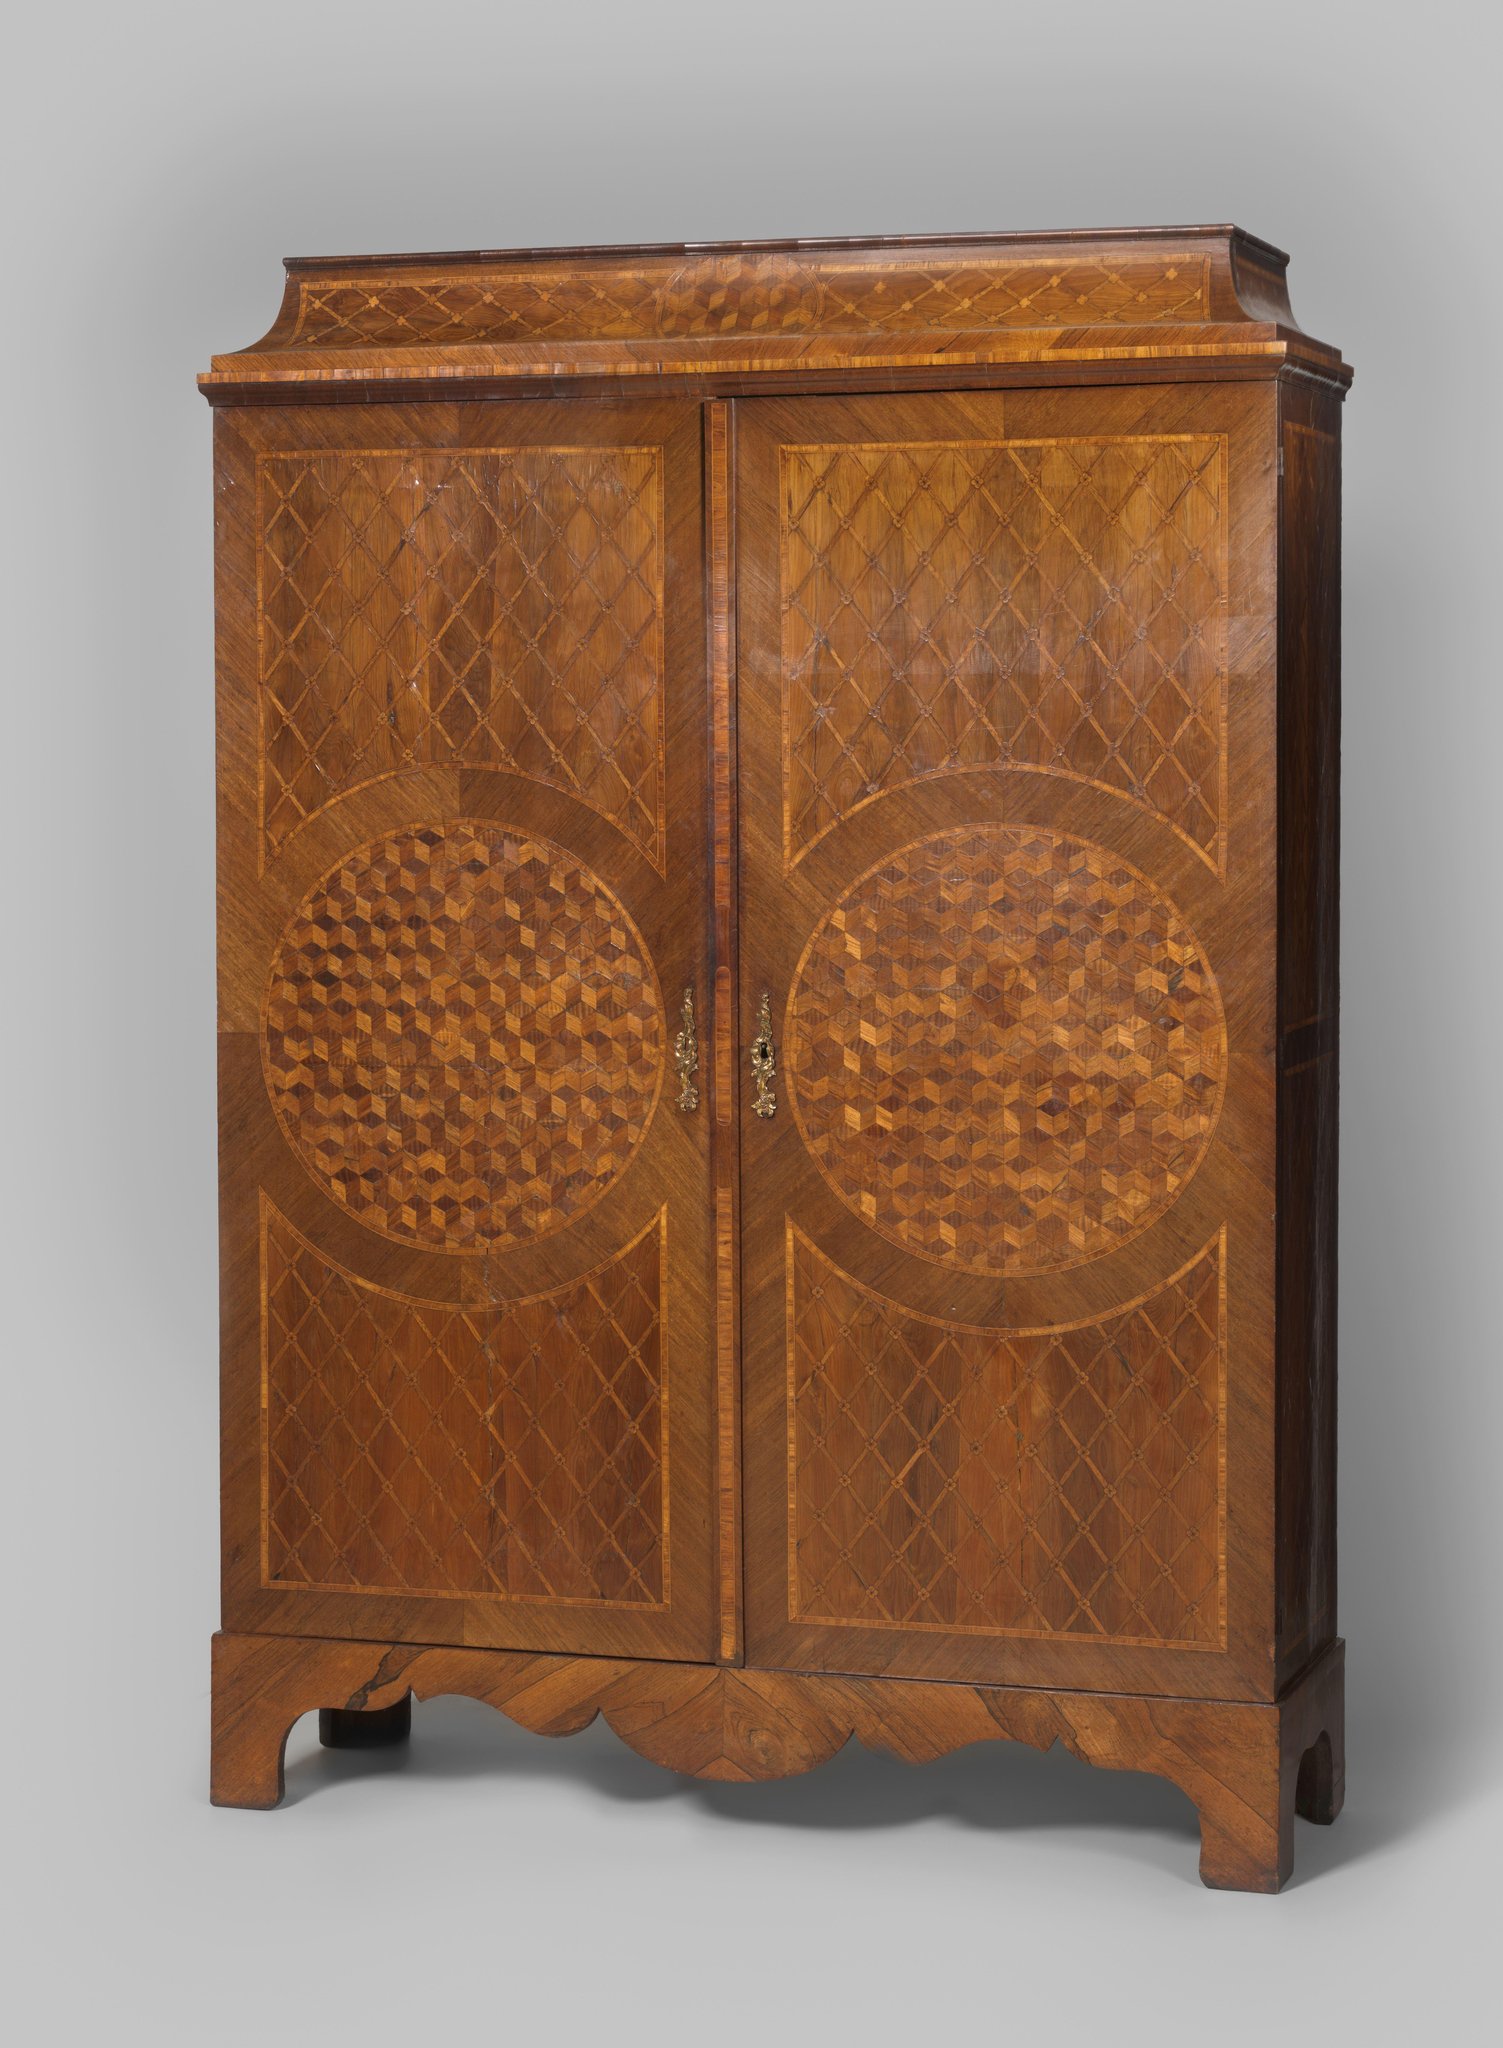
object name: furniture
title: Kast, belijmd met meerdere houtsoorten. Deuren met in het midden een cirkelvormig veld met kubuspatroon waaromheen een ruitpatroon.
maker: Anonymous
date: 1750-1775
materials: bronze, wood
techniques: gilding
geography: northern netherlands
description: Cabinet. Oak, veneered with tulipwood and other woods, the interior with a writing slab and a large number of drawers. Netherlands, c. 1770 - 1785.